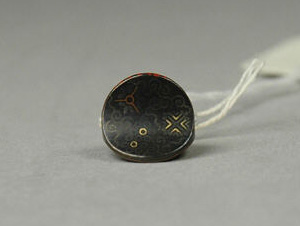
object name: ojime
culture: japanese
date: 1801-1900